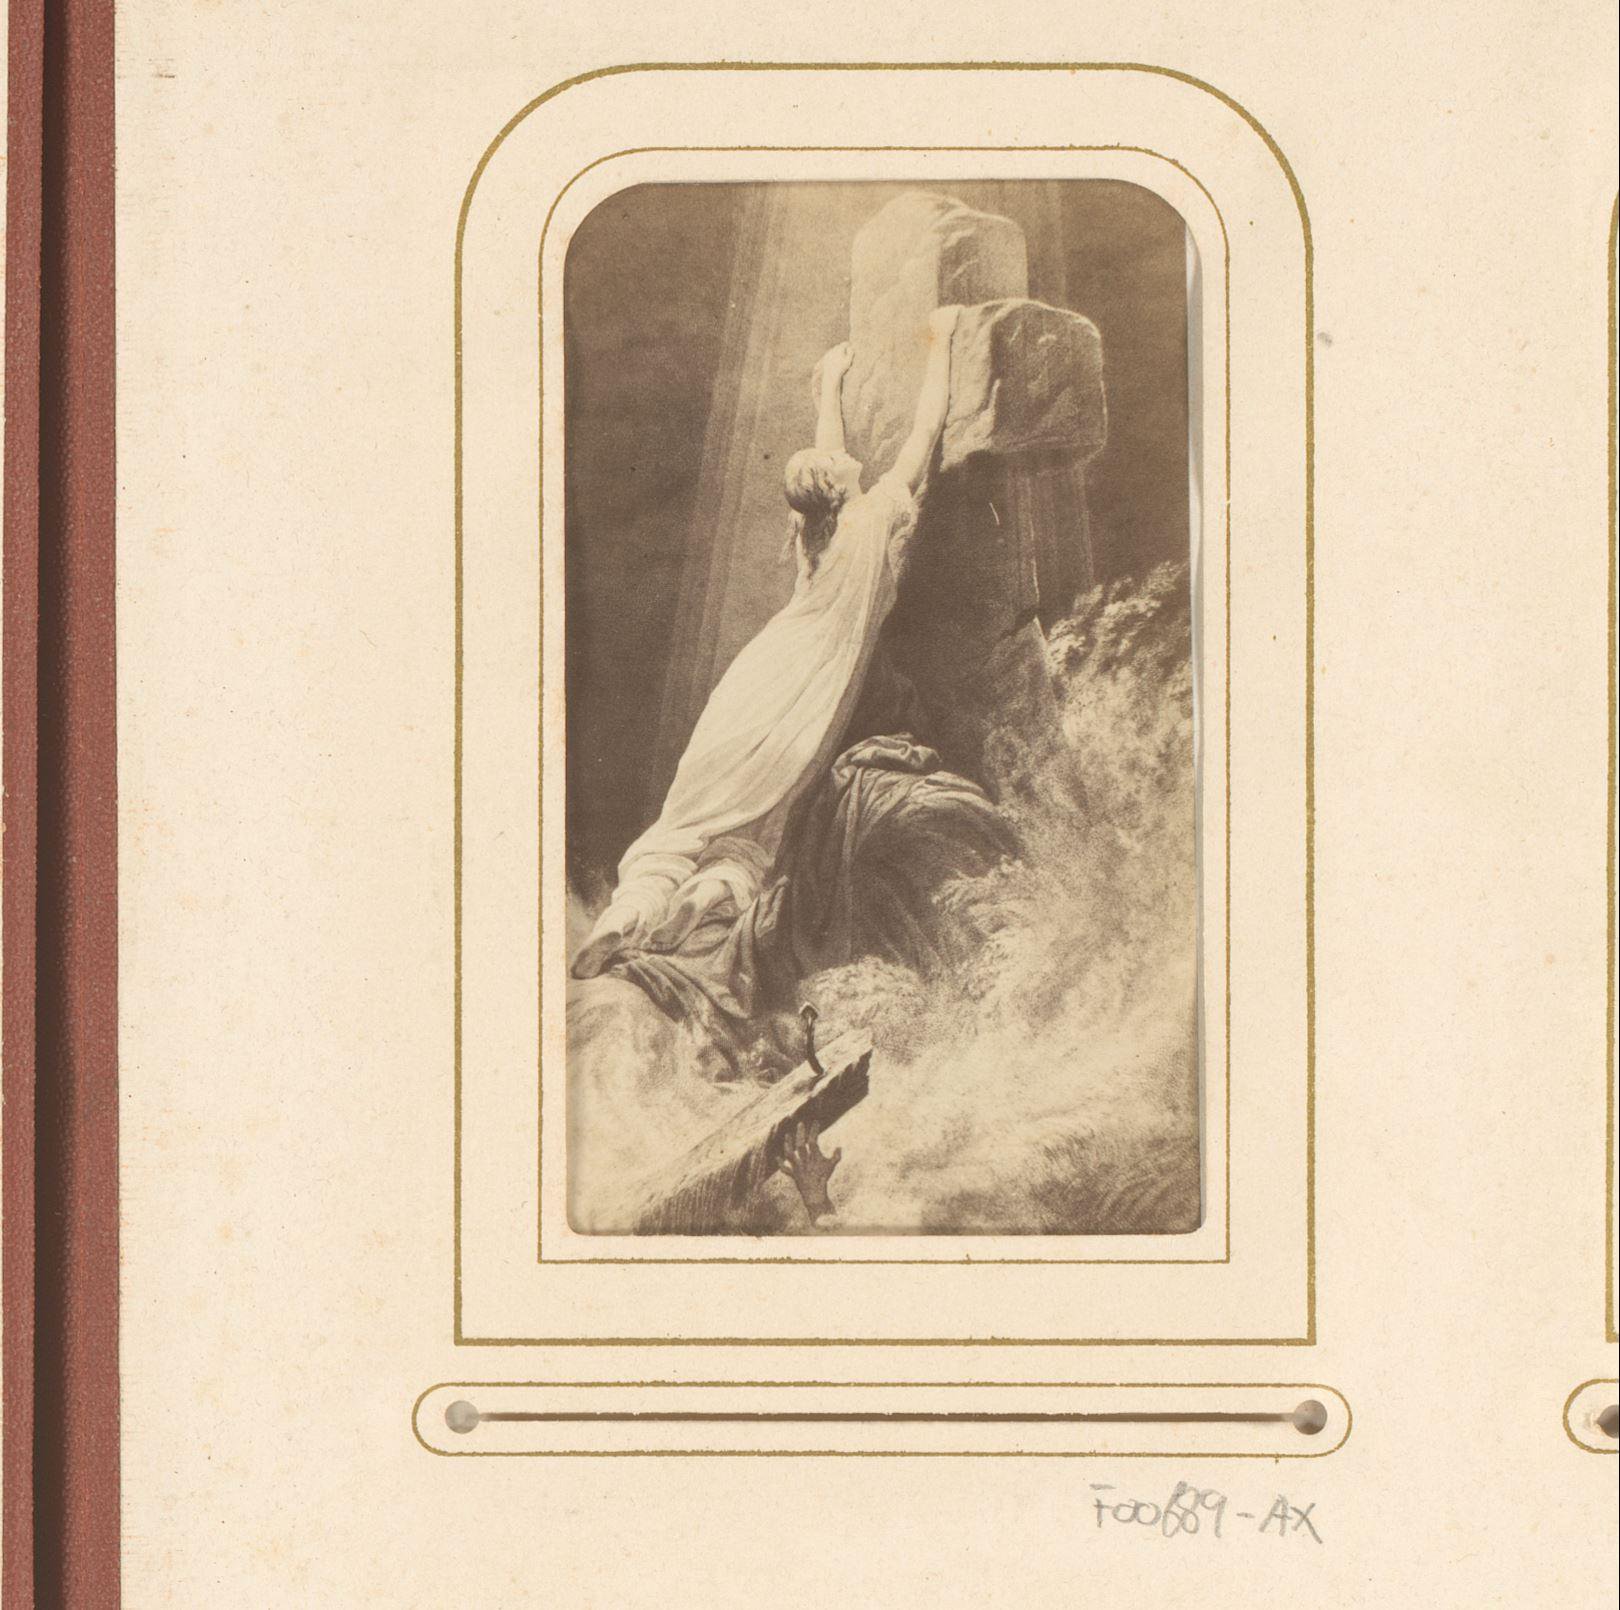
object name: carte de visite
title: Fotoreproductie van Der Rettungsfelsen naar Johannes Adam Simon Oertel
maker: Anonymous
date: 1860-1880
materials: cardboard, photographic support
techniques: albumen print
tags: other kinds of grave-markers, e.g. cross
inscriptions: annotation: ‘der rettungsfelsen’